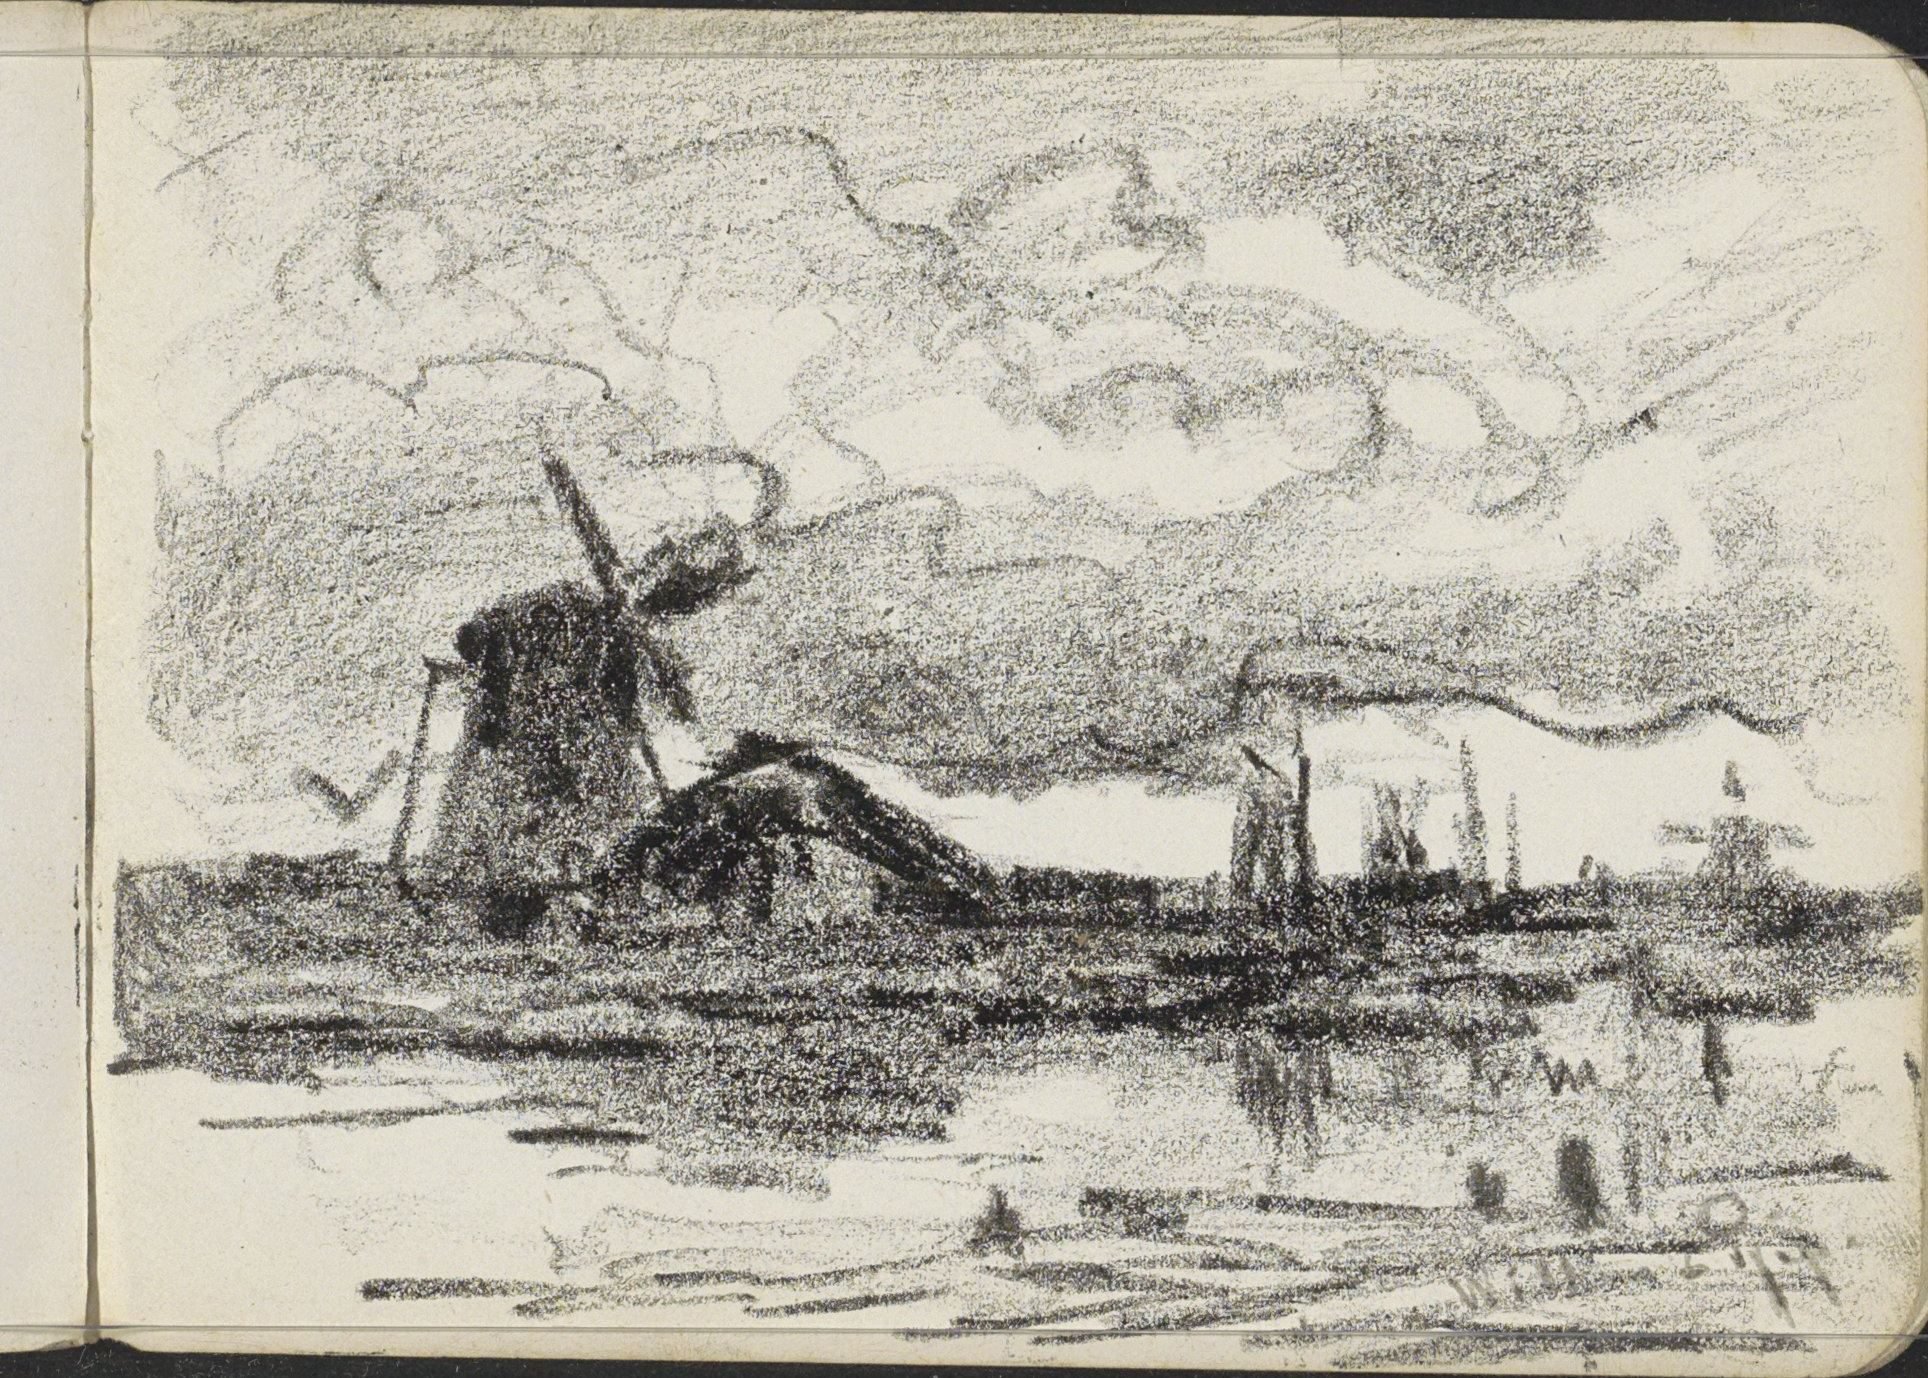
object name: sketchbook leaf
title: Rivierlandschap met molens en een boerderij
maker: willem cornelis rip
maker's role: draughtsman, painter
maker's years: 1856-1922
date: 1907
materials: chalk, paper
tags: river, windmill in landscape, farm (building)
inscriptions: signature: ‘Willem Rip’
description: Blad 38 recto uit een schetsboek met 41 bladen.